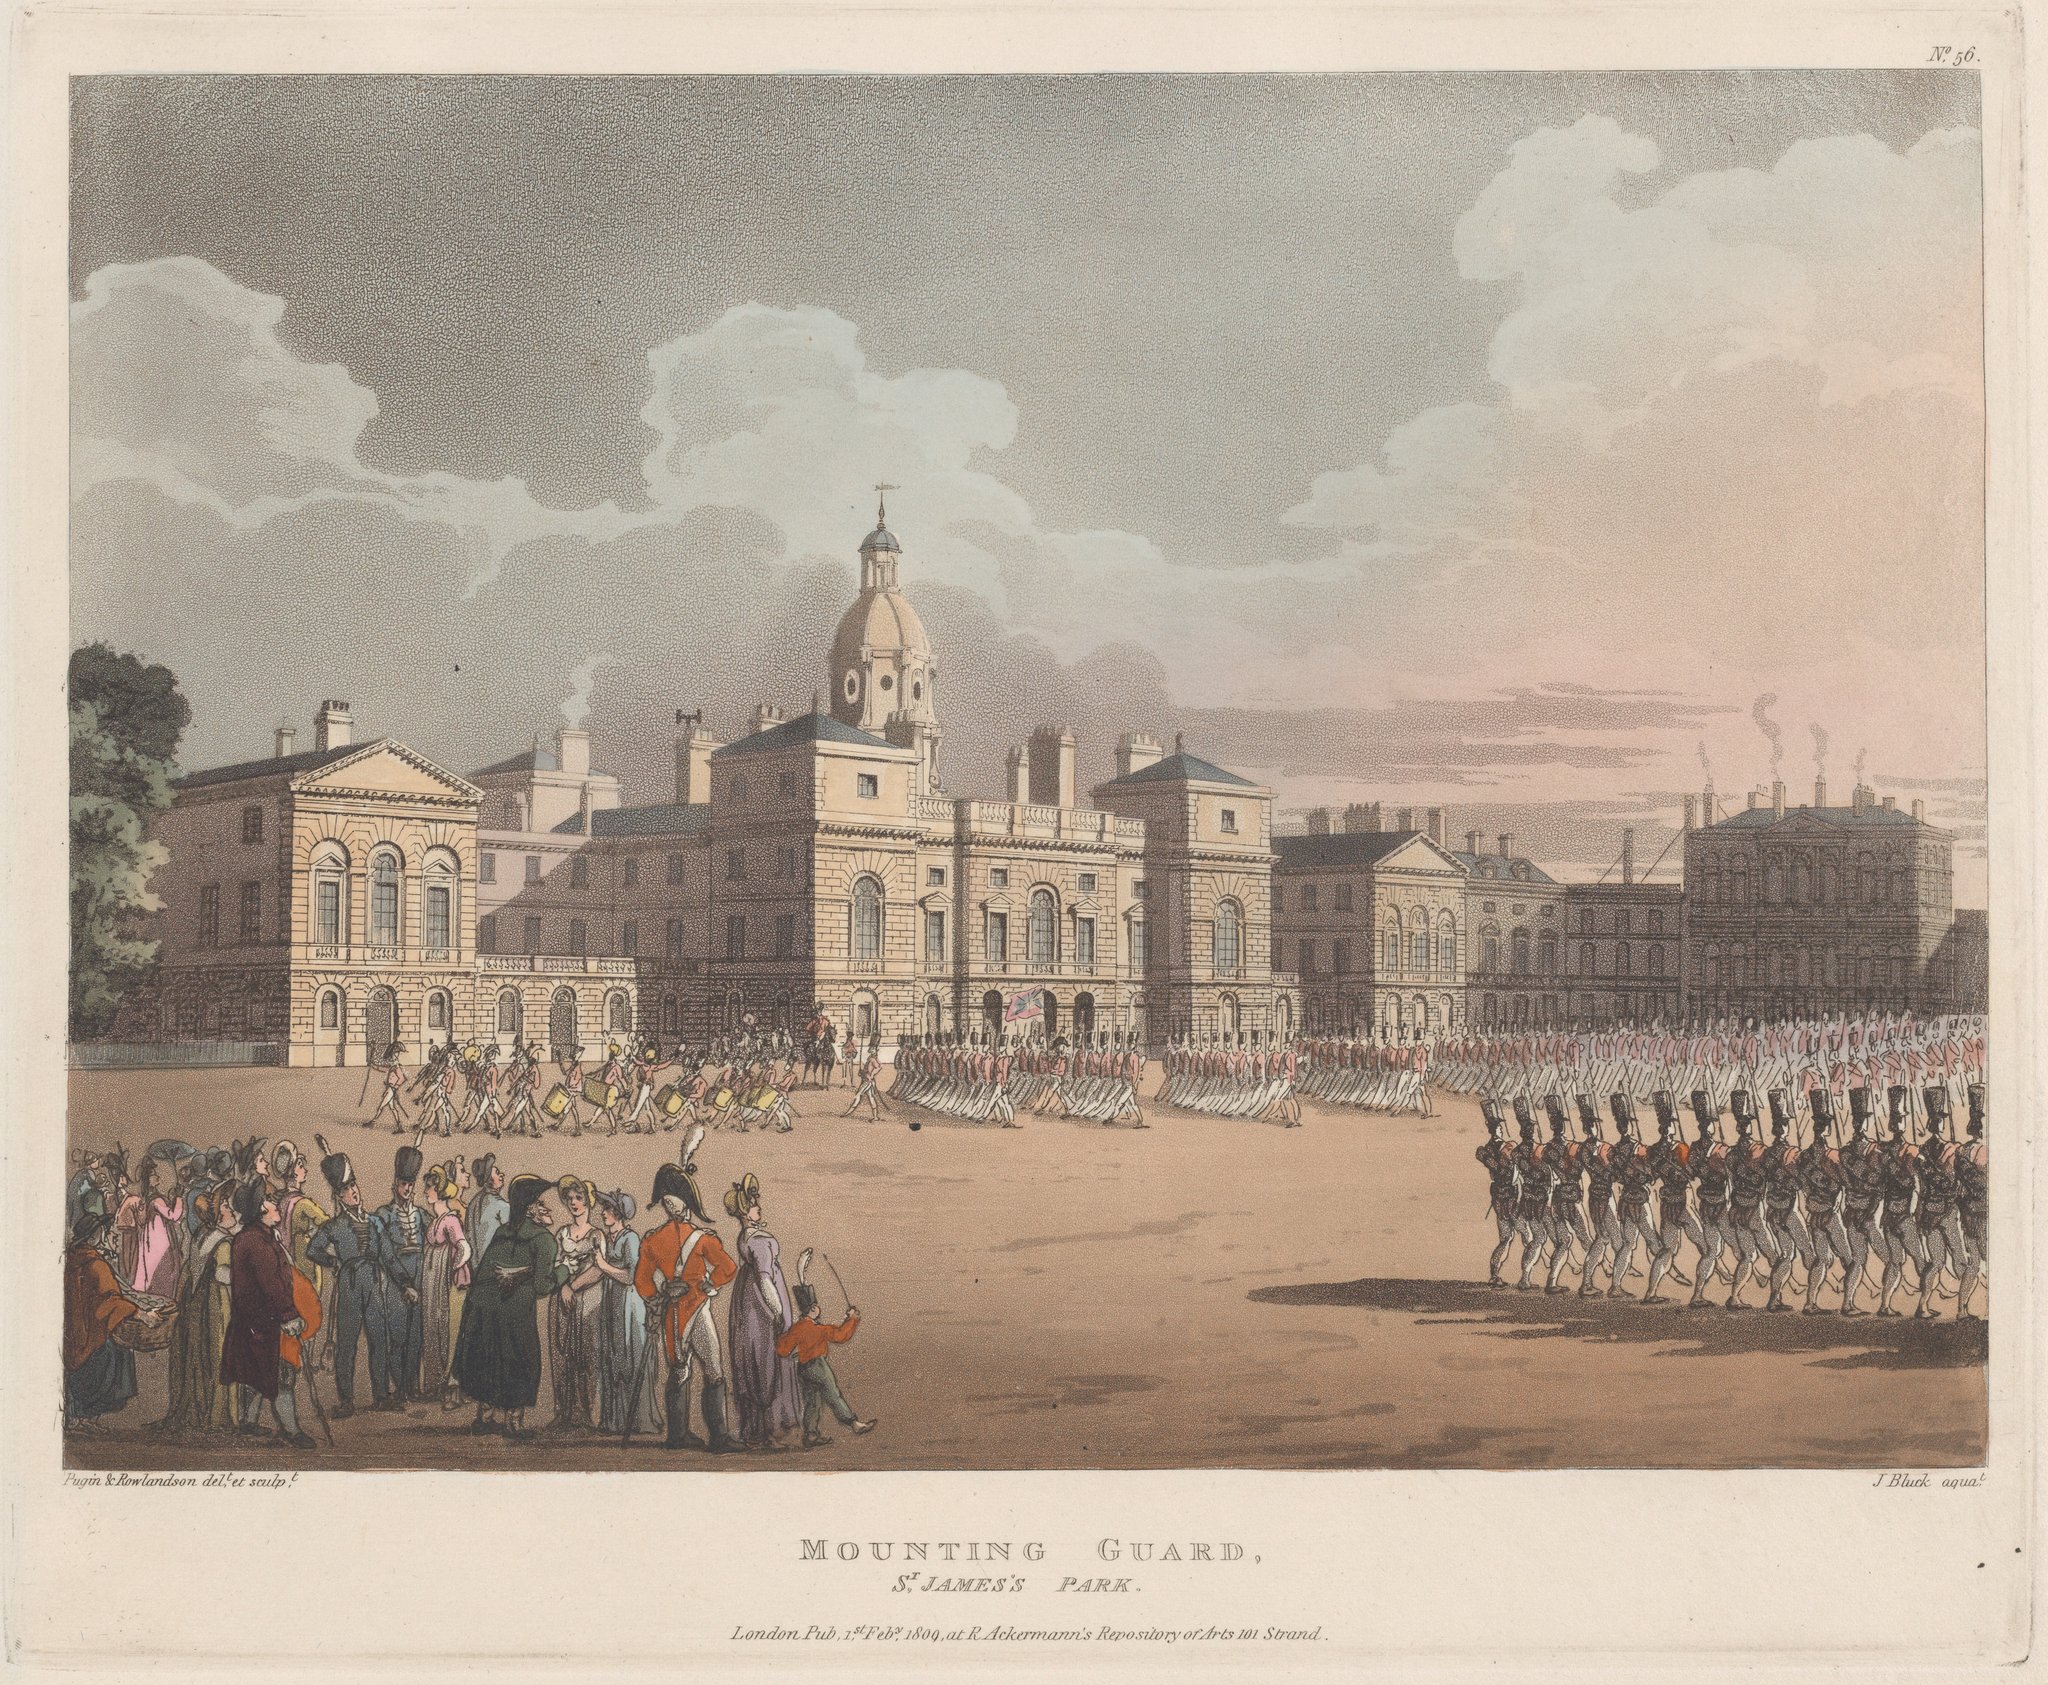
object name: print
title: Mounting Guard, St. James's Park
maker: thomas rowlandson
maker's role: artist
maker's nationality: british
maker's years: 1757-1827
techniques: aquatint, etching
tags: soldiers,london